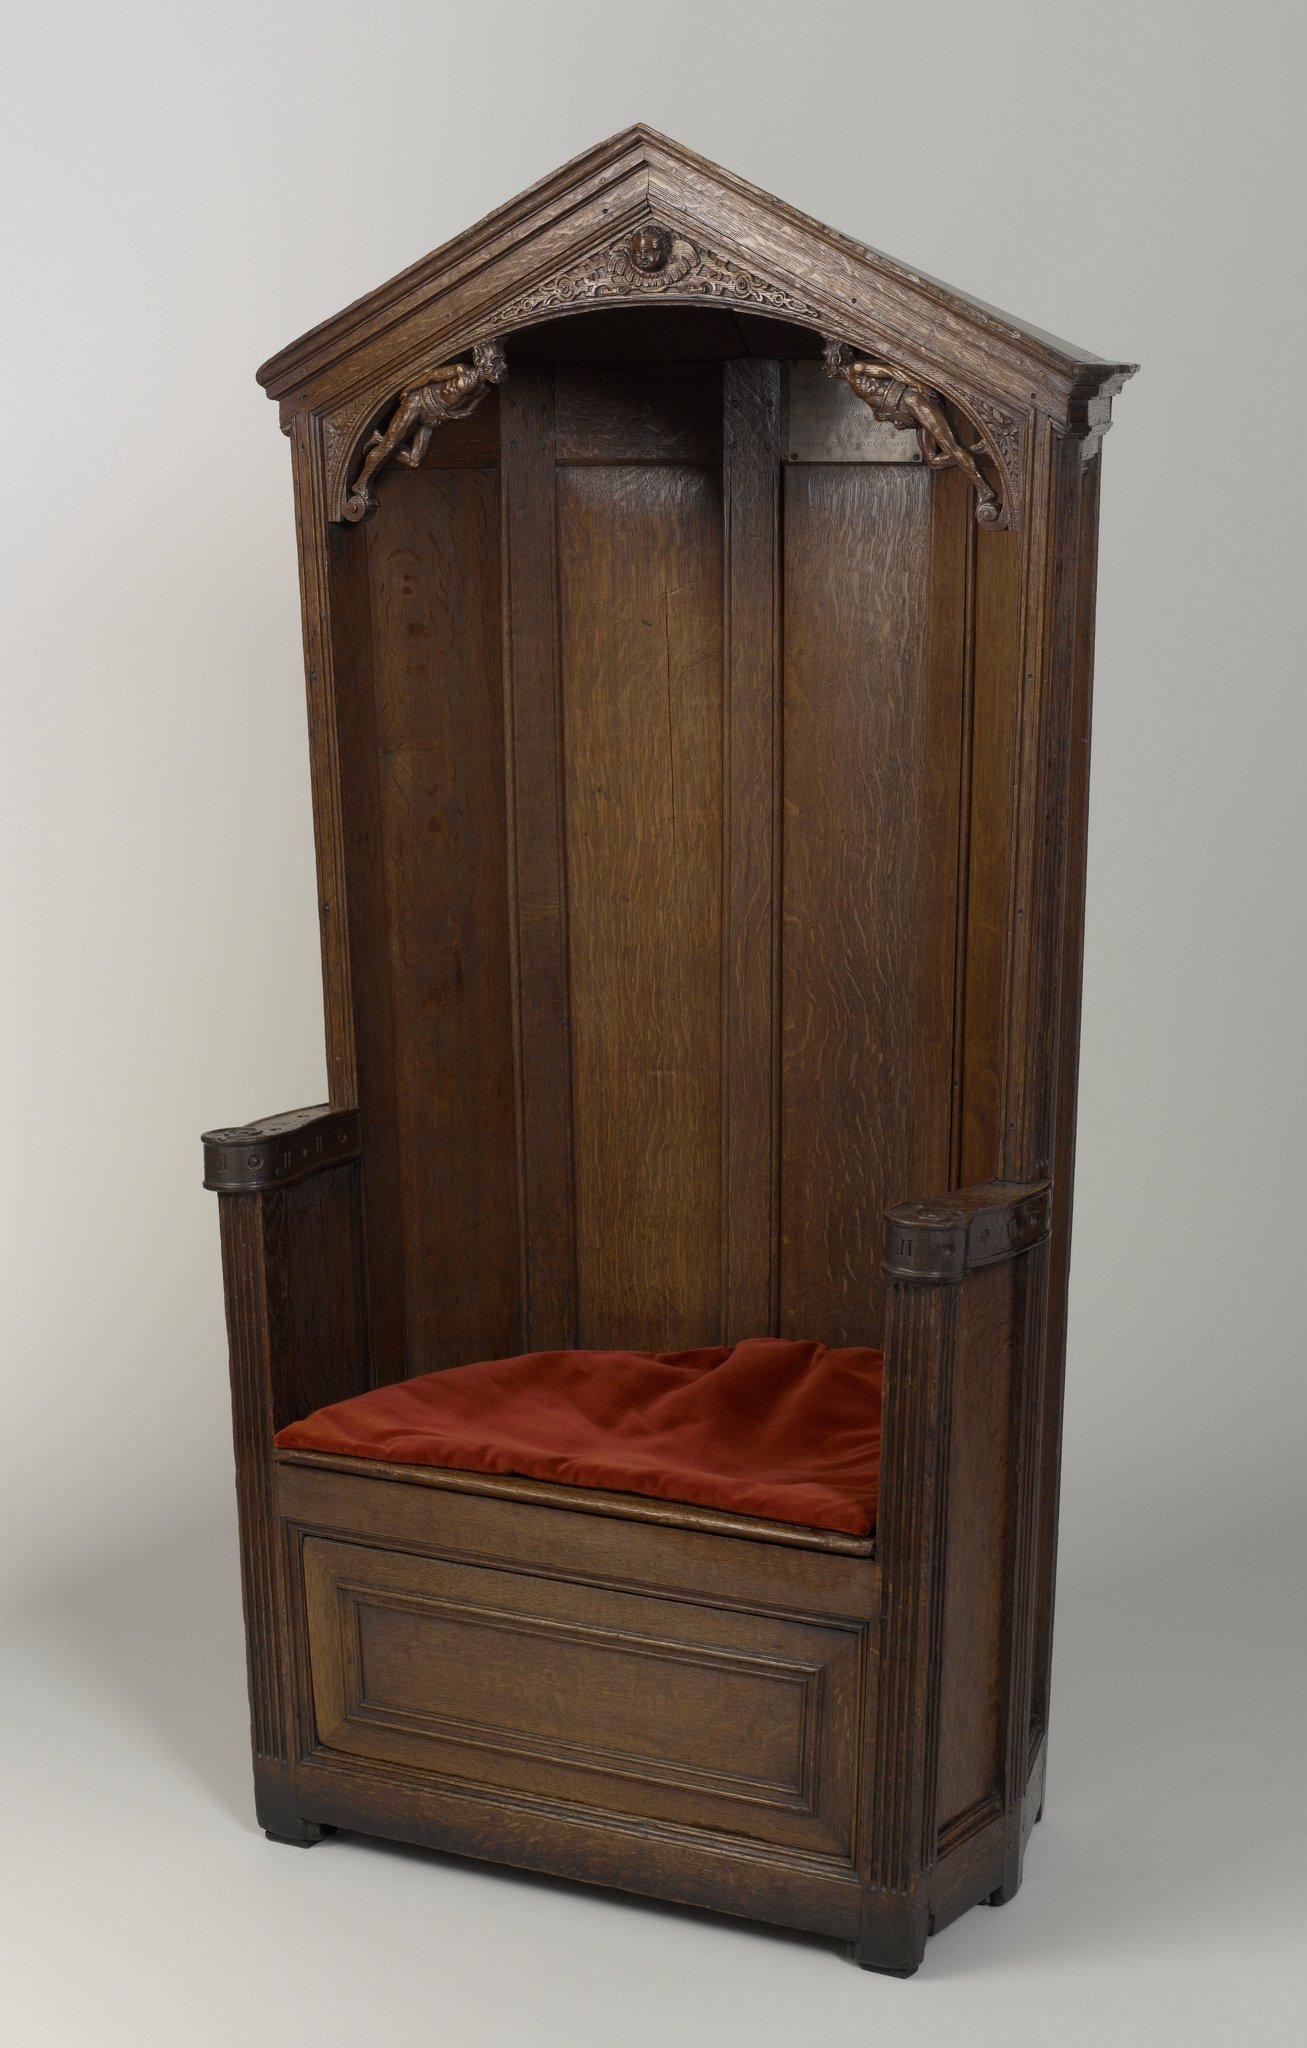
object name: seating furniture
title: Armstoel van eikenhout, met huifkap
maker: Anonymous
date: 1560-1580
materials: wood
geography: northern netherlands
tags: delft, william i (prince of orange), cherubs, i.e. children's heads with wings, satyr(s) (in general)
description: Armchair. Oak. Netherlands (Amsterdam?), c. 1560-1570. In 1578 this chair was owned by the burgomaster of Amsterdam, Dirck Jansz de Graeff. Tradition has it that William of Orange then sat in it when he visited Amsterdam. This 'historical fact' is recorded on a metal plate which De Graeff's descendants placed on the chair when they loaned it to the Koninklijk Oudheidkundig Genootschap in 1877. On loan from the De Graeff family to the Koninklijk Oudheidkundig Genootschap.